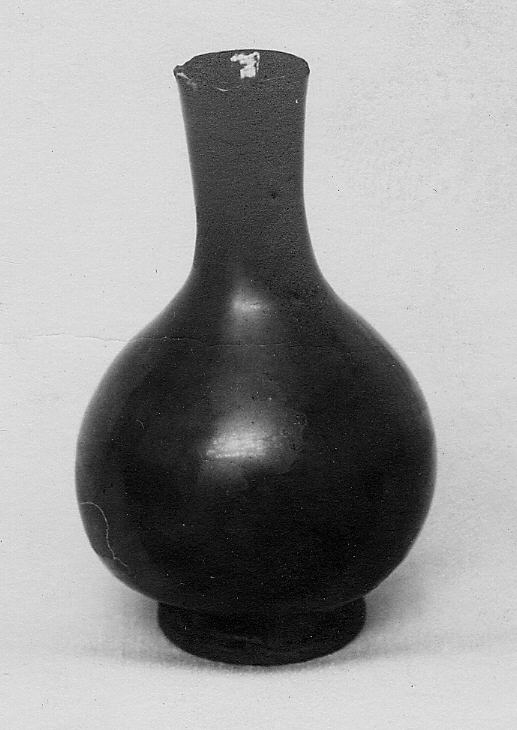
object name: snuff bottle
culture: chinese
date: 1662-1722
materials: porcelain